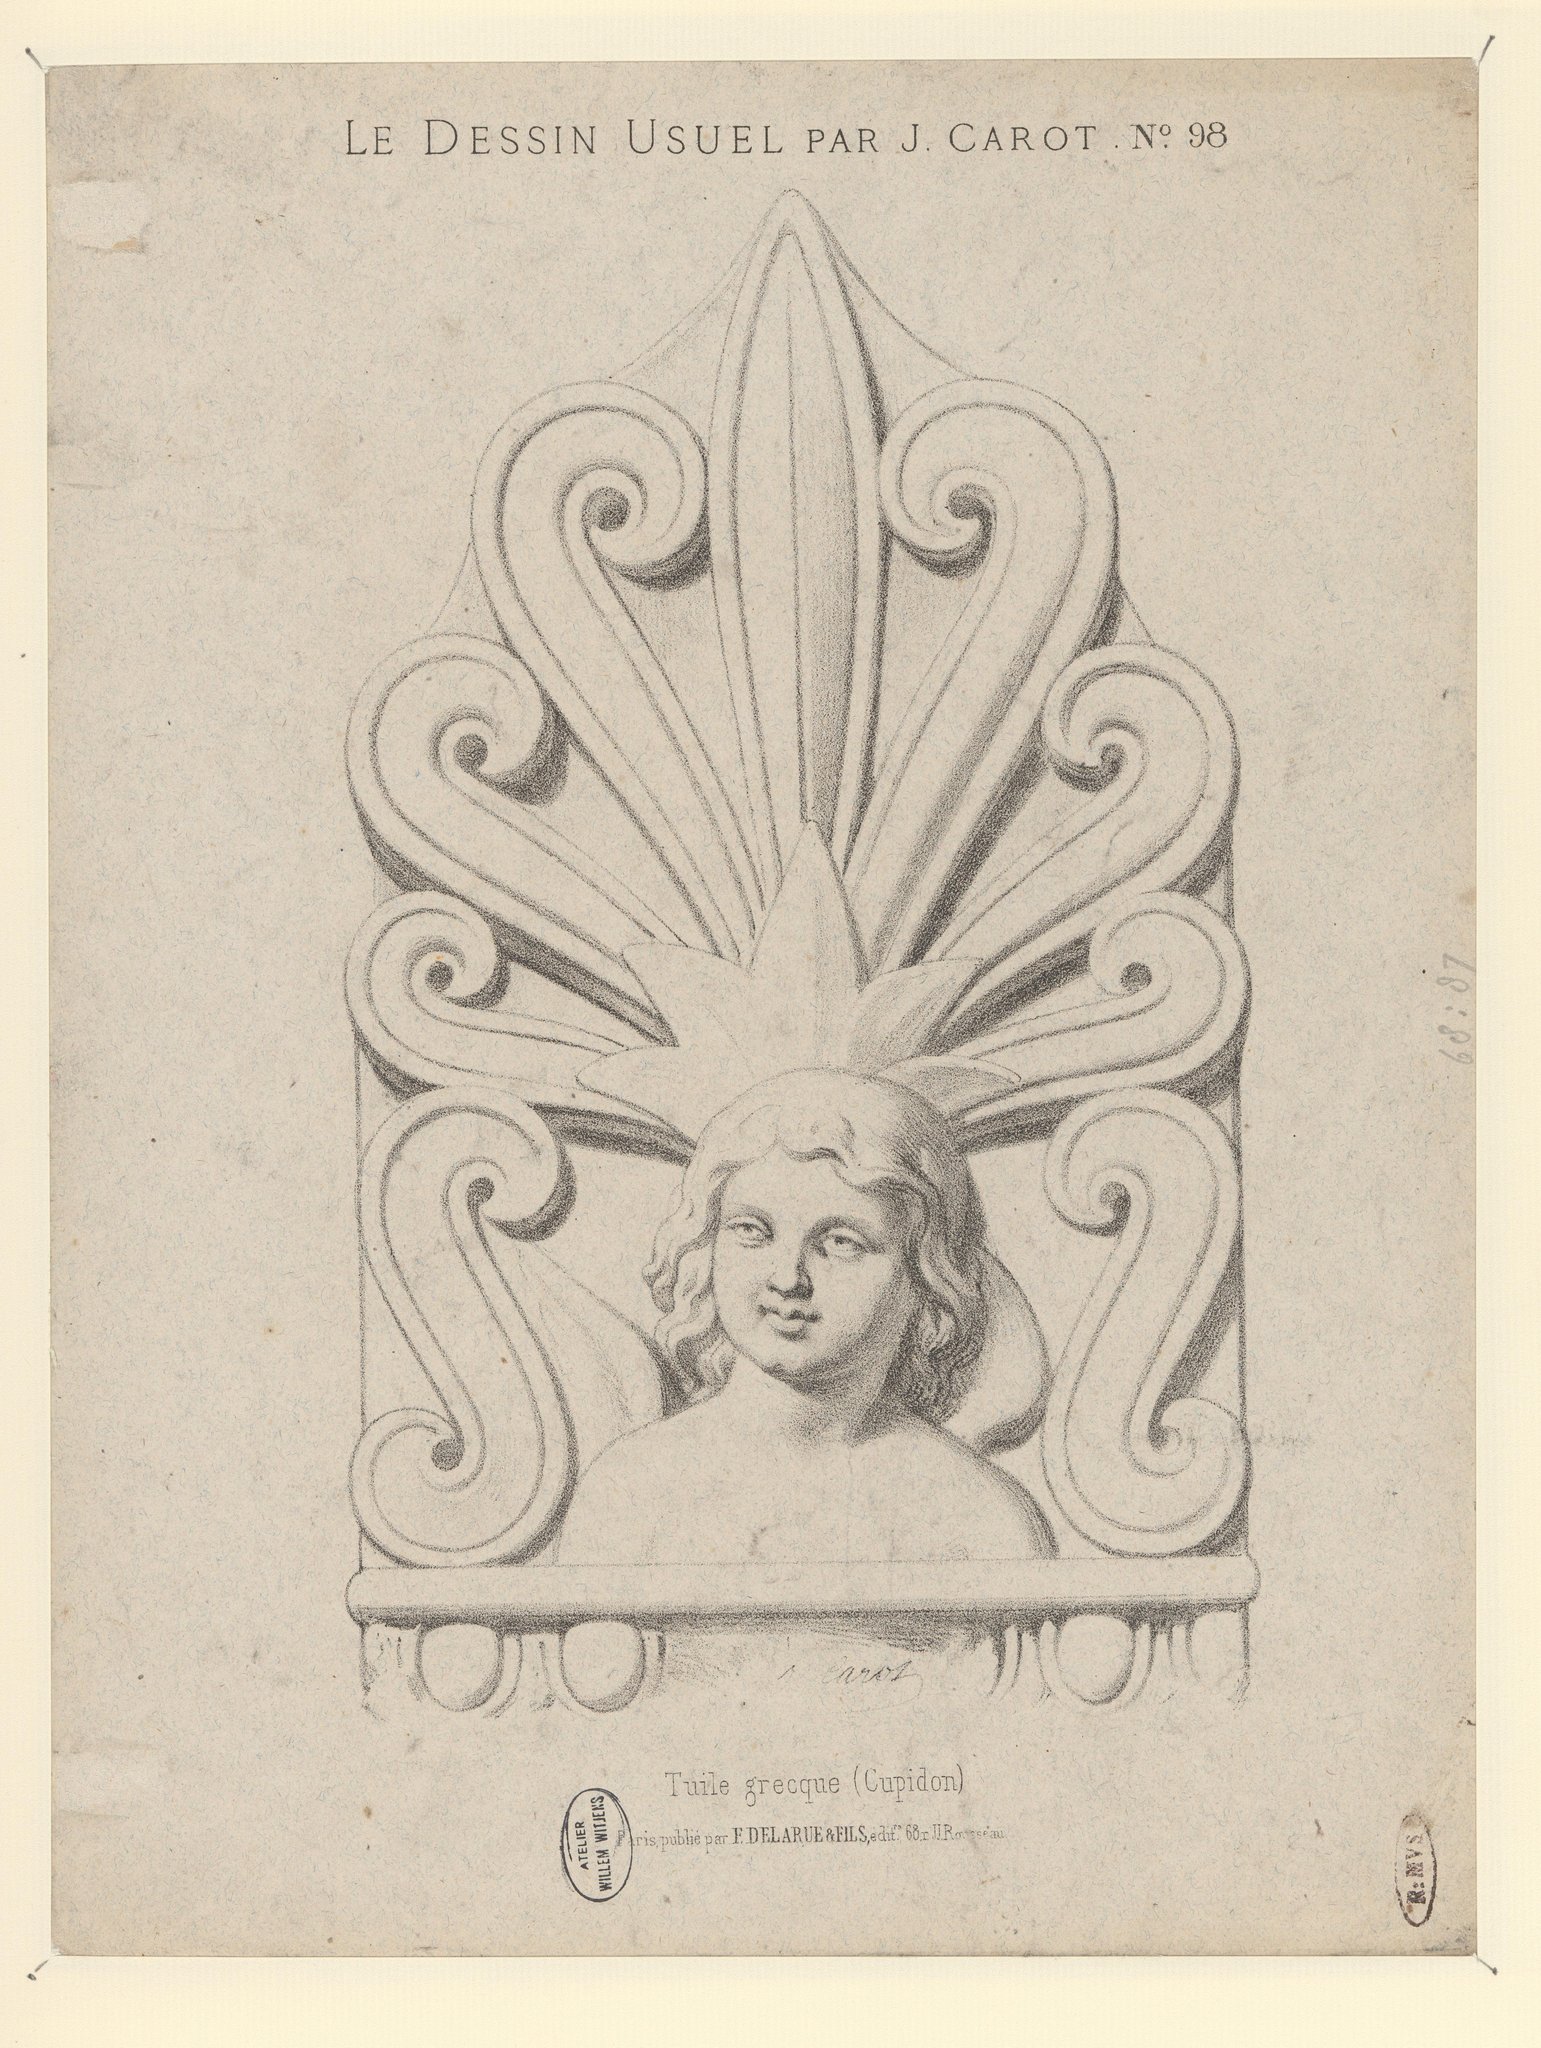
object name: print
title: Architectonische tekeningen door Jean Carot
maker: jean carot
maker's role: print maker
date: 1867-1868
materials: paper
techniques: lithograph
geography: paris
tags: sculpture, surface decorations ~ architecture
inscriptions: collector's mark: Lugt 2228, stamp: ‘Atelier/ Willem Witjens’